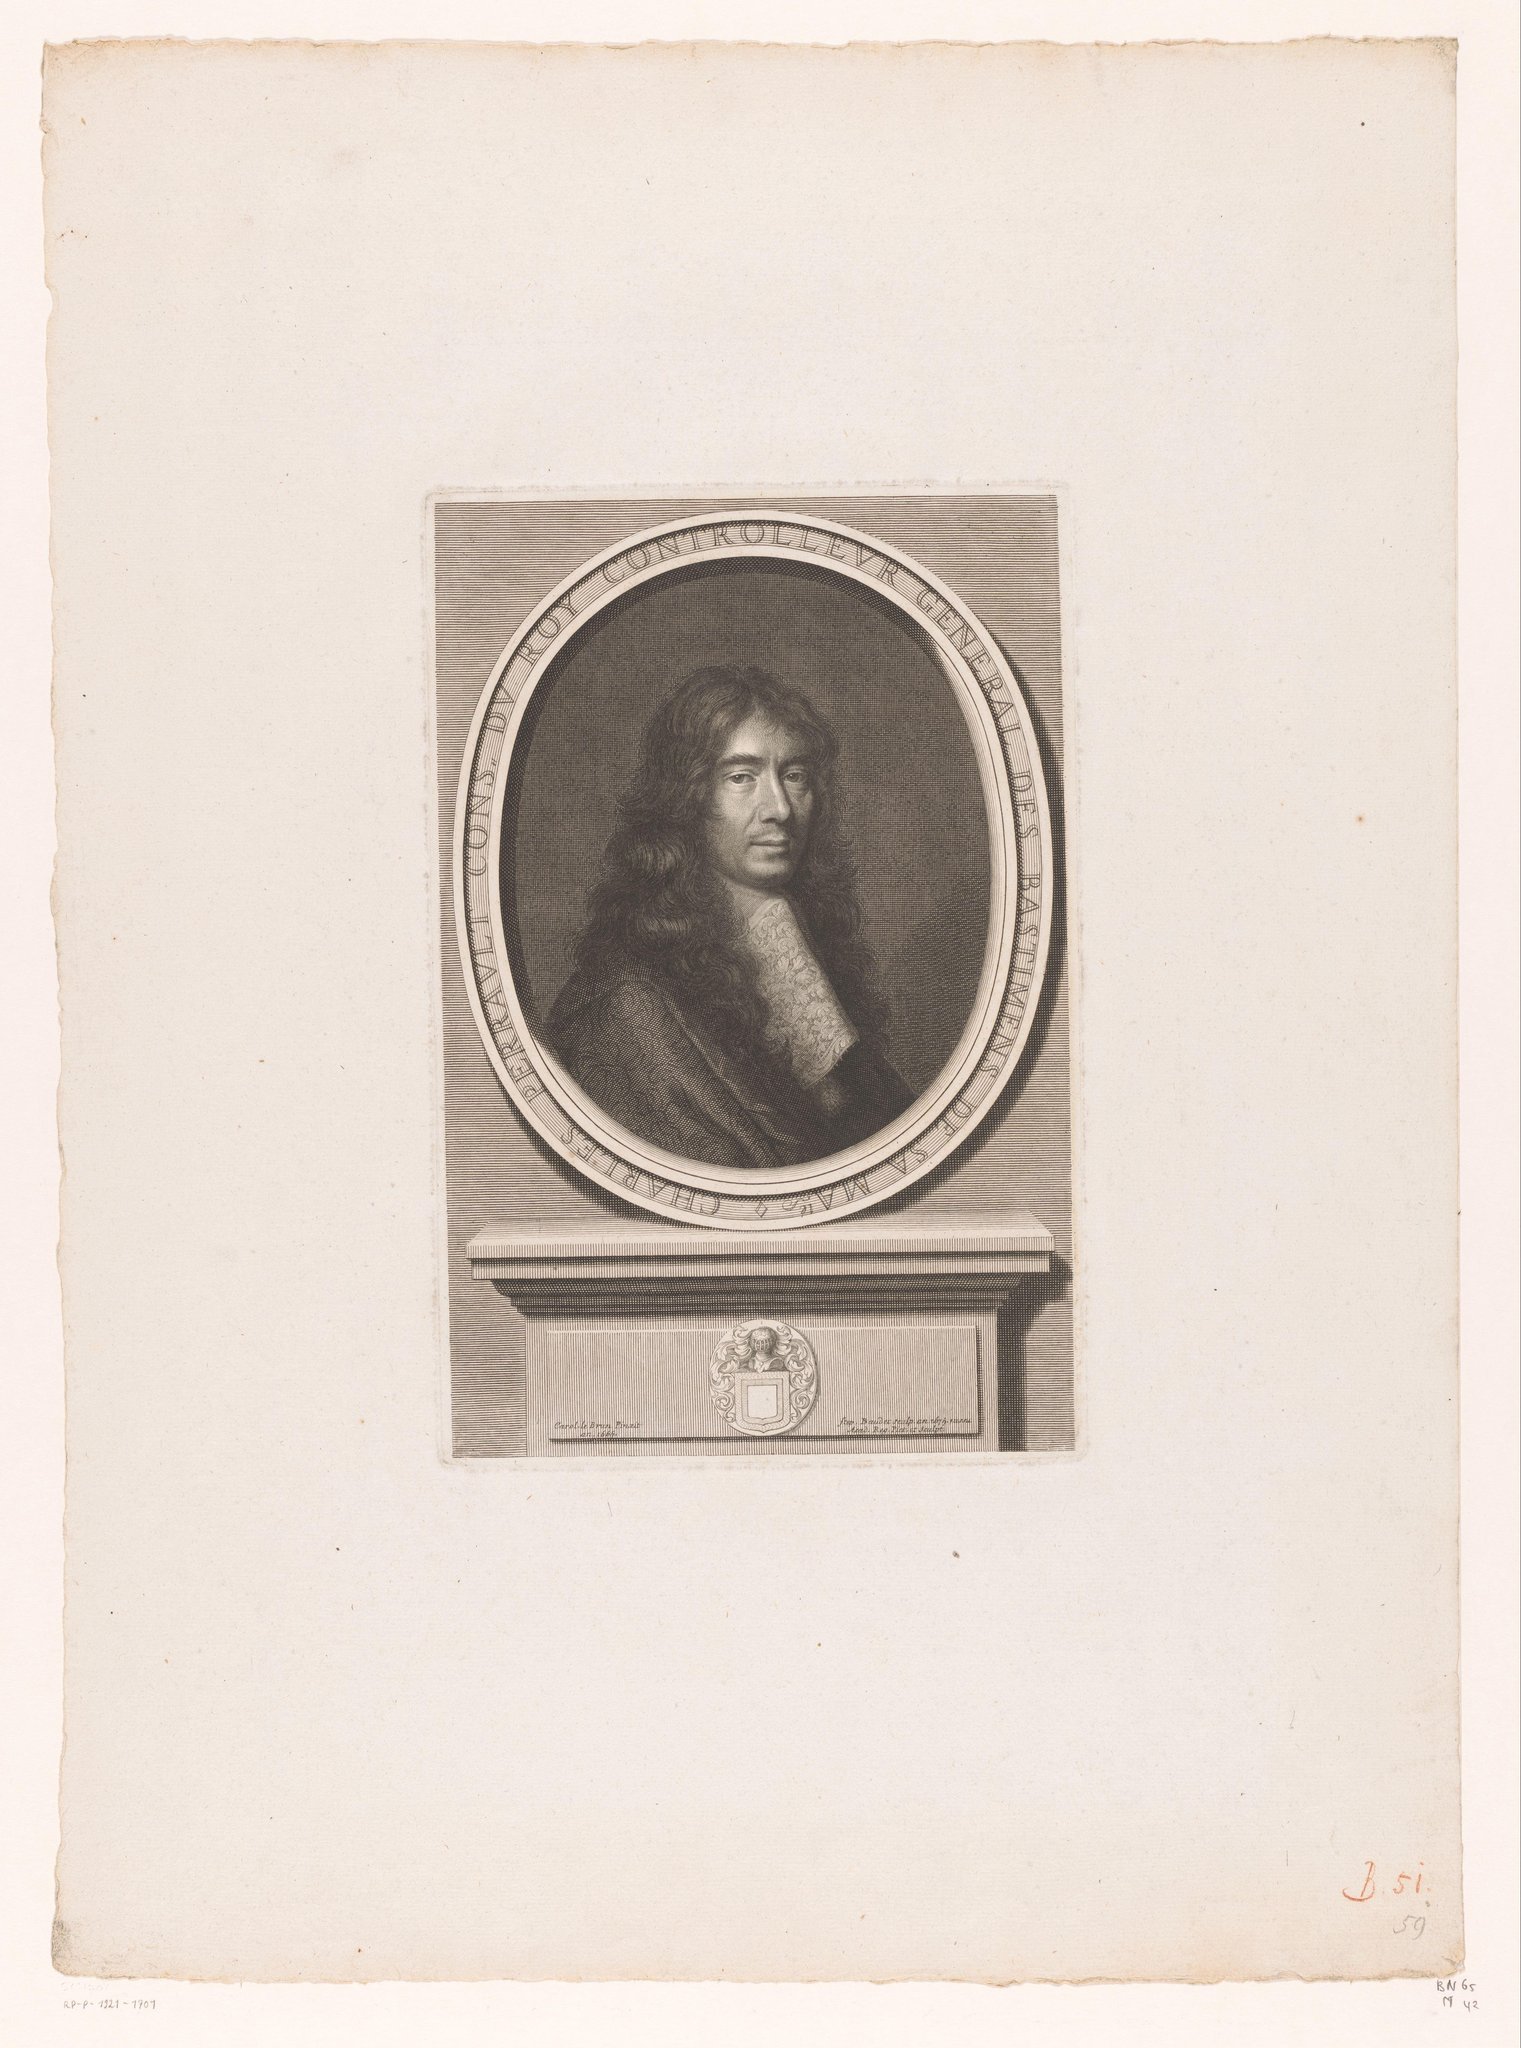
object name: print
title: Portret van Charles Perrault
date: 1675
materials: paper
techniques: engraving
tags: paris, charles perrault, historical persons, portrait of a writer, armorial bearing, heraldry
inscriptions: collector's mark: Lugt 2233